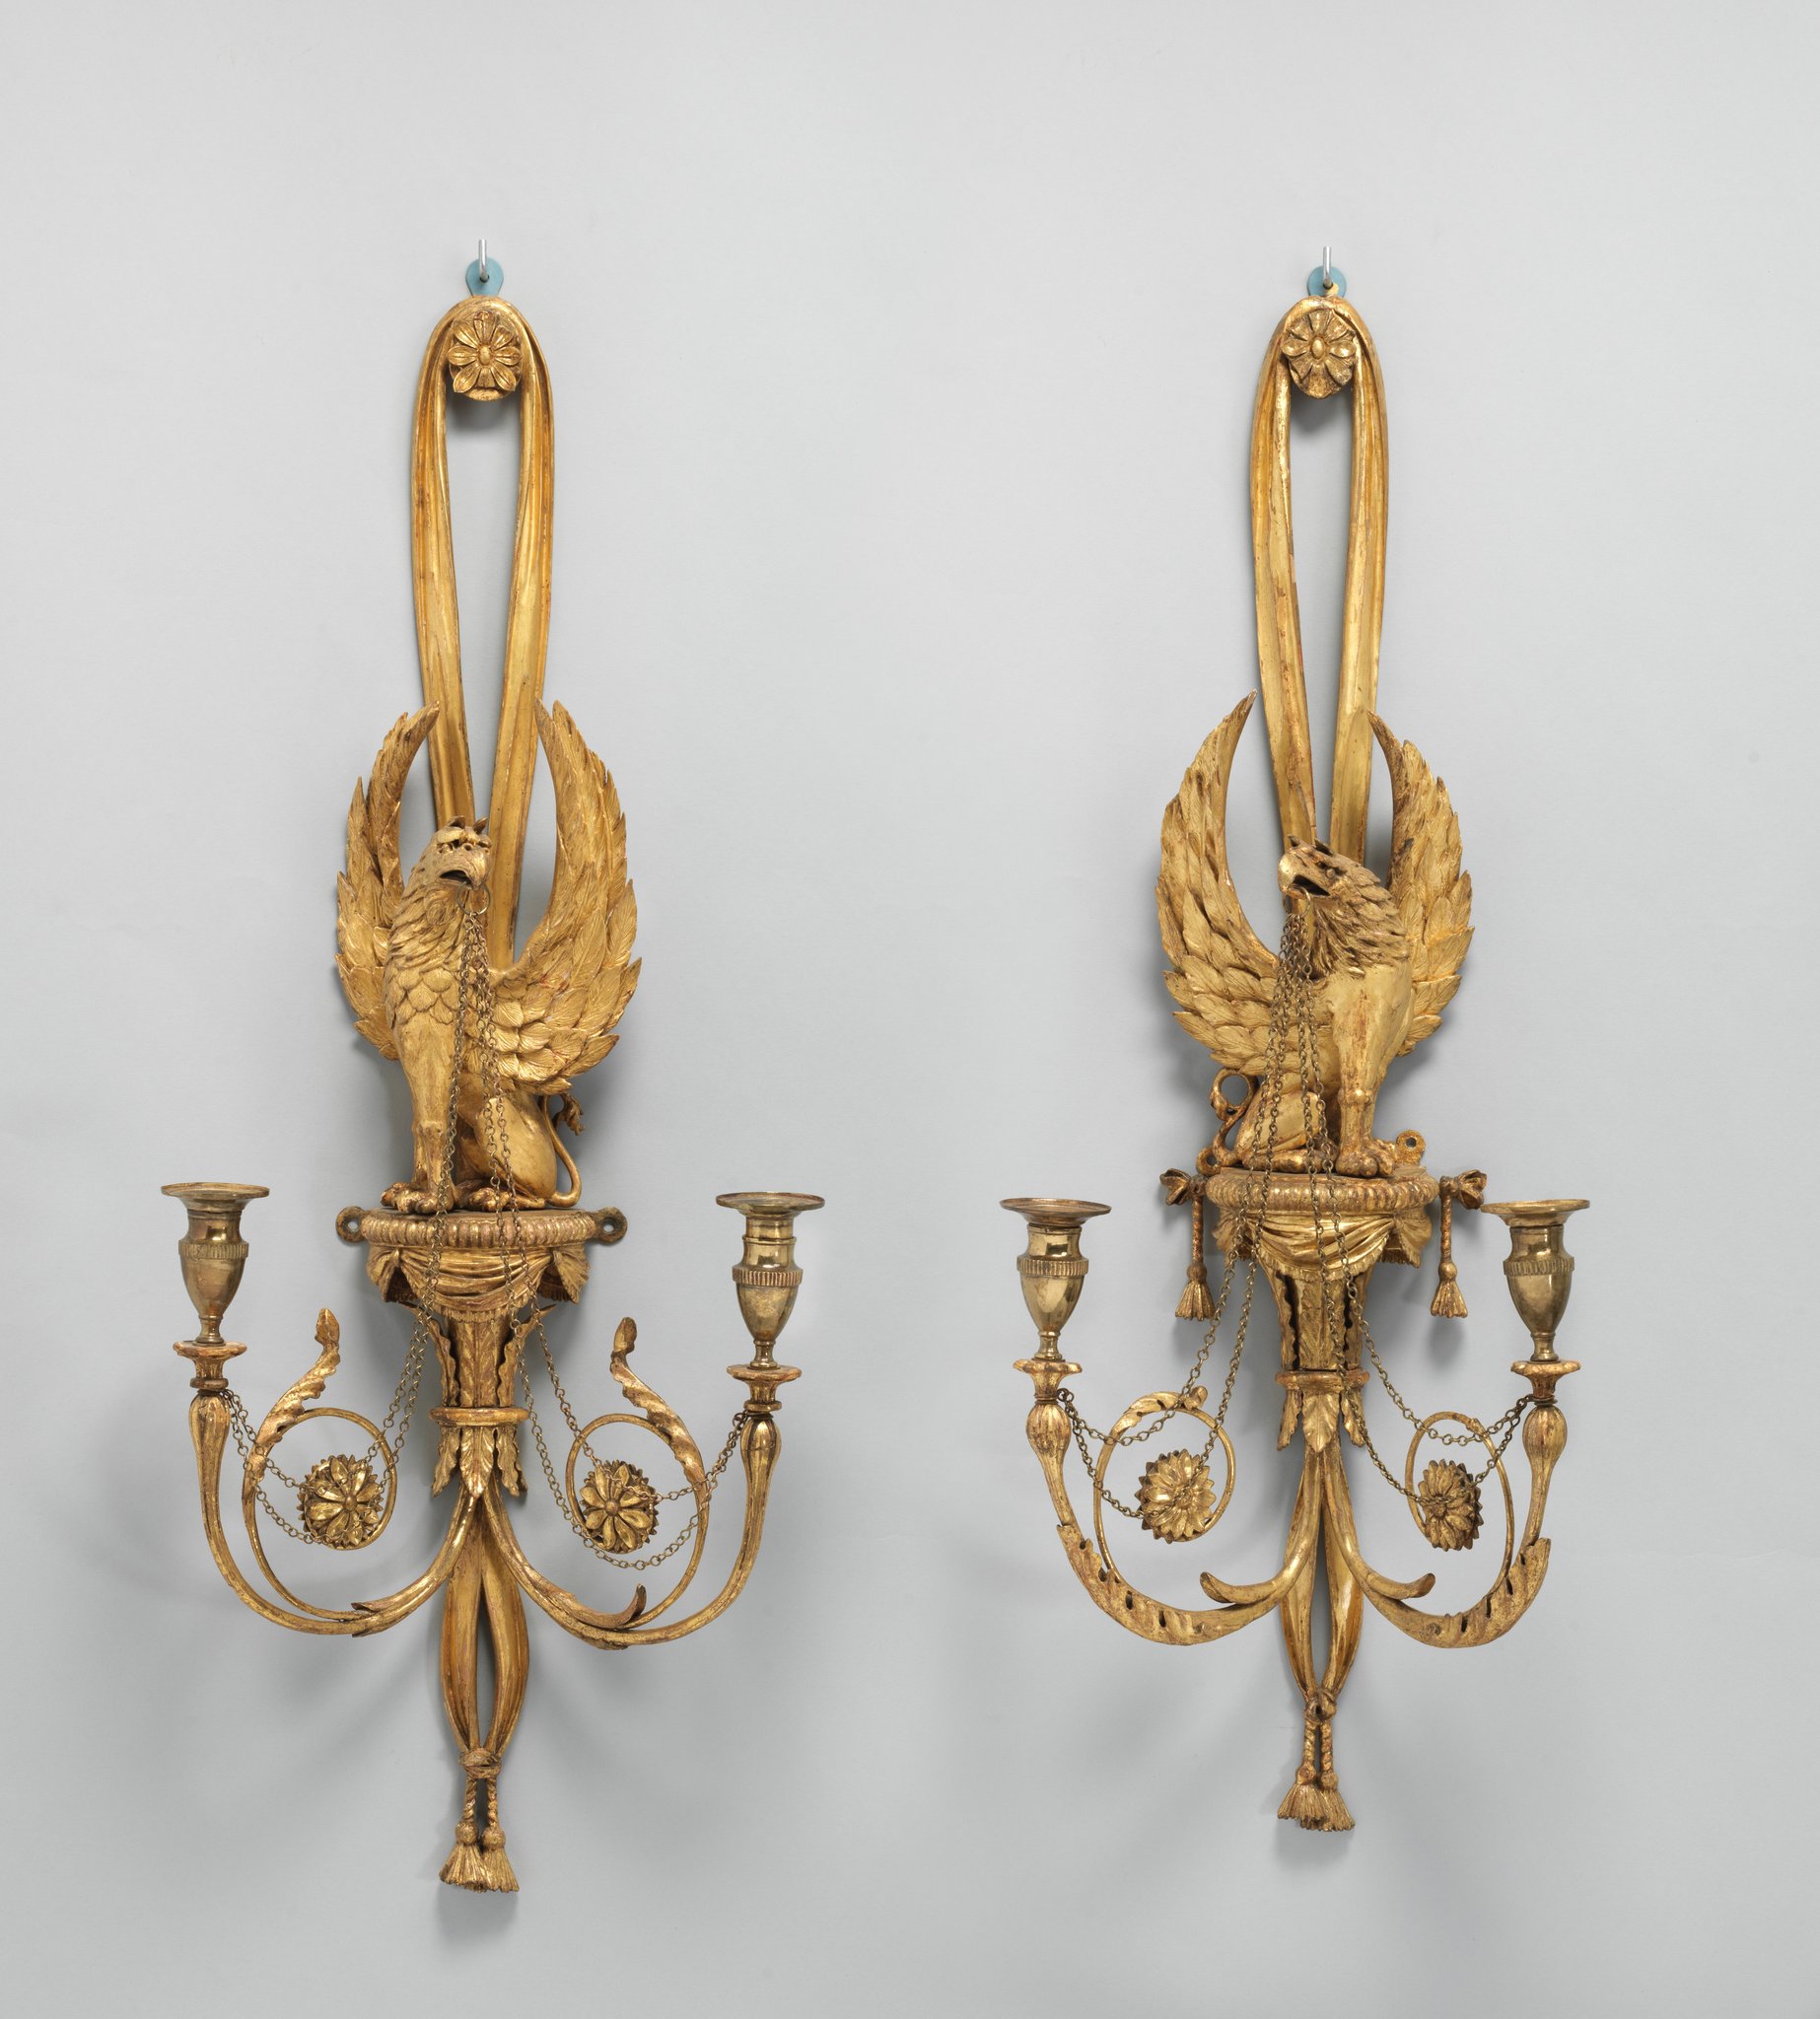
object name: sconce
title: Sconce (one of a pair)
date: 1790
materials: gesso, gilt brass, wood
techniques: gilding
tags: griffins